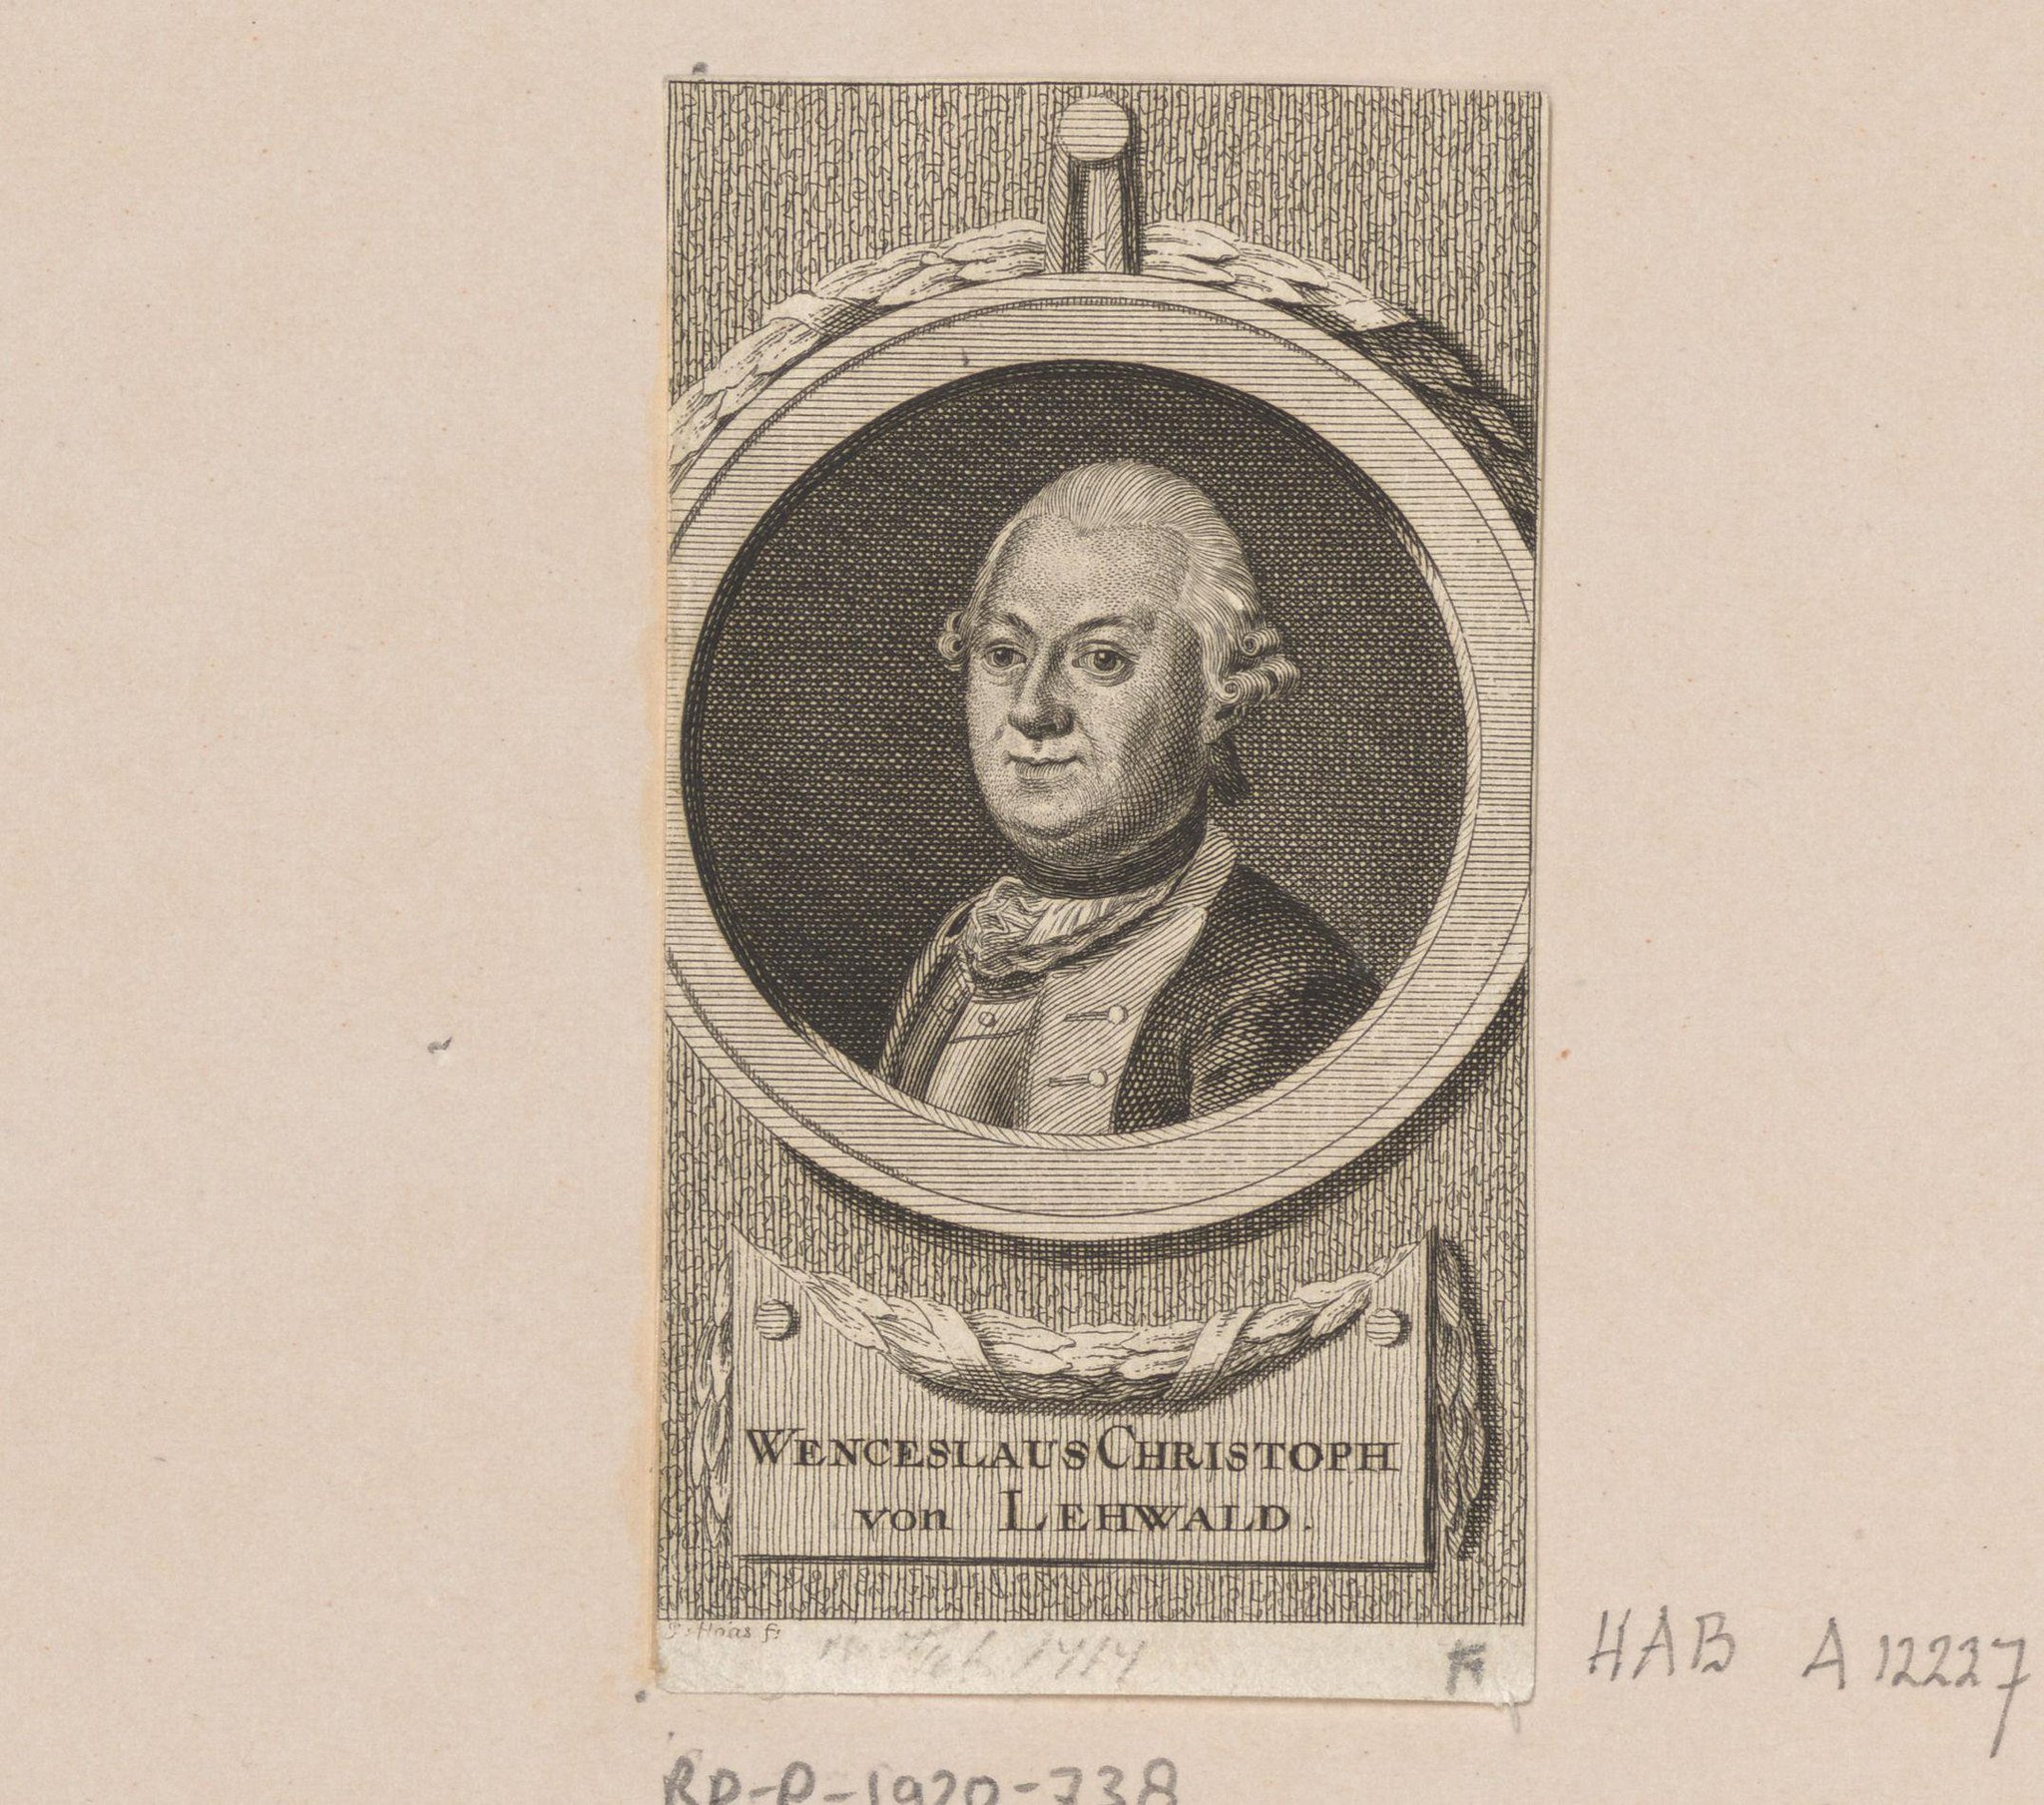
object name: print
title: Portret van Wenzel Christoph von Lehwaldt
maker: peter haas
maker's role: print maker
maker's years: 1754-1804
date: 1764-1804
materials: paper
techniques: etching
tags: ornament ~ medallion, commander-in-chief, general, marshal, historical persons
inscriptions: collector's mark: Lugt 2228